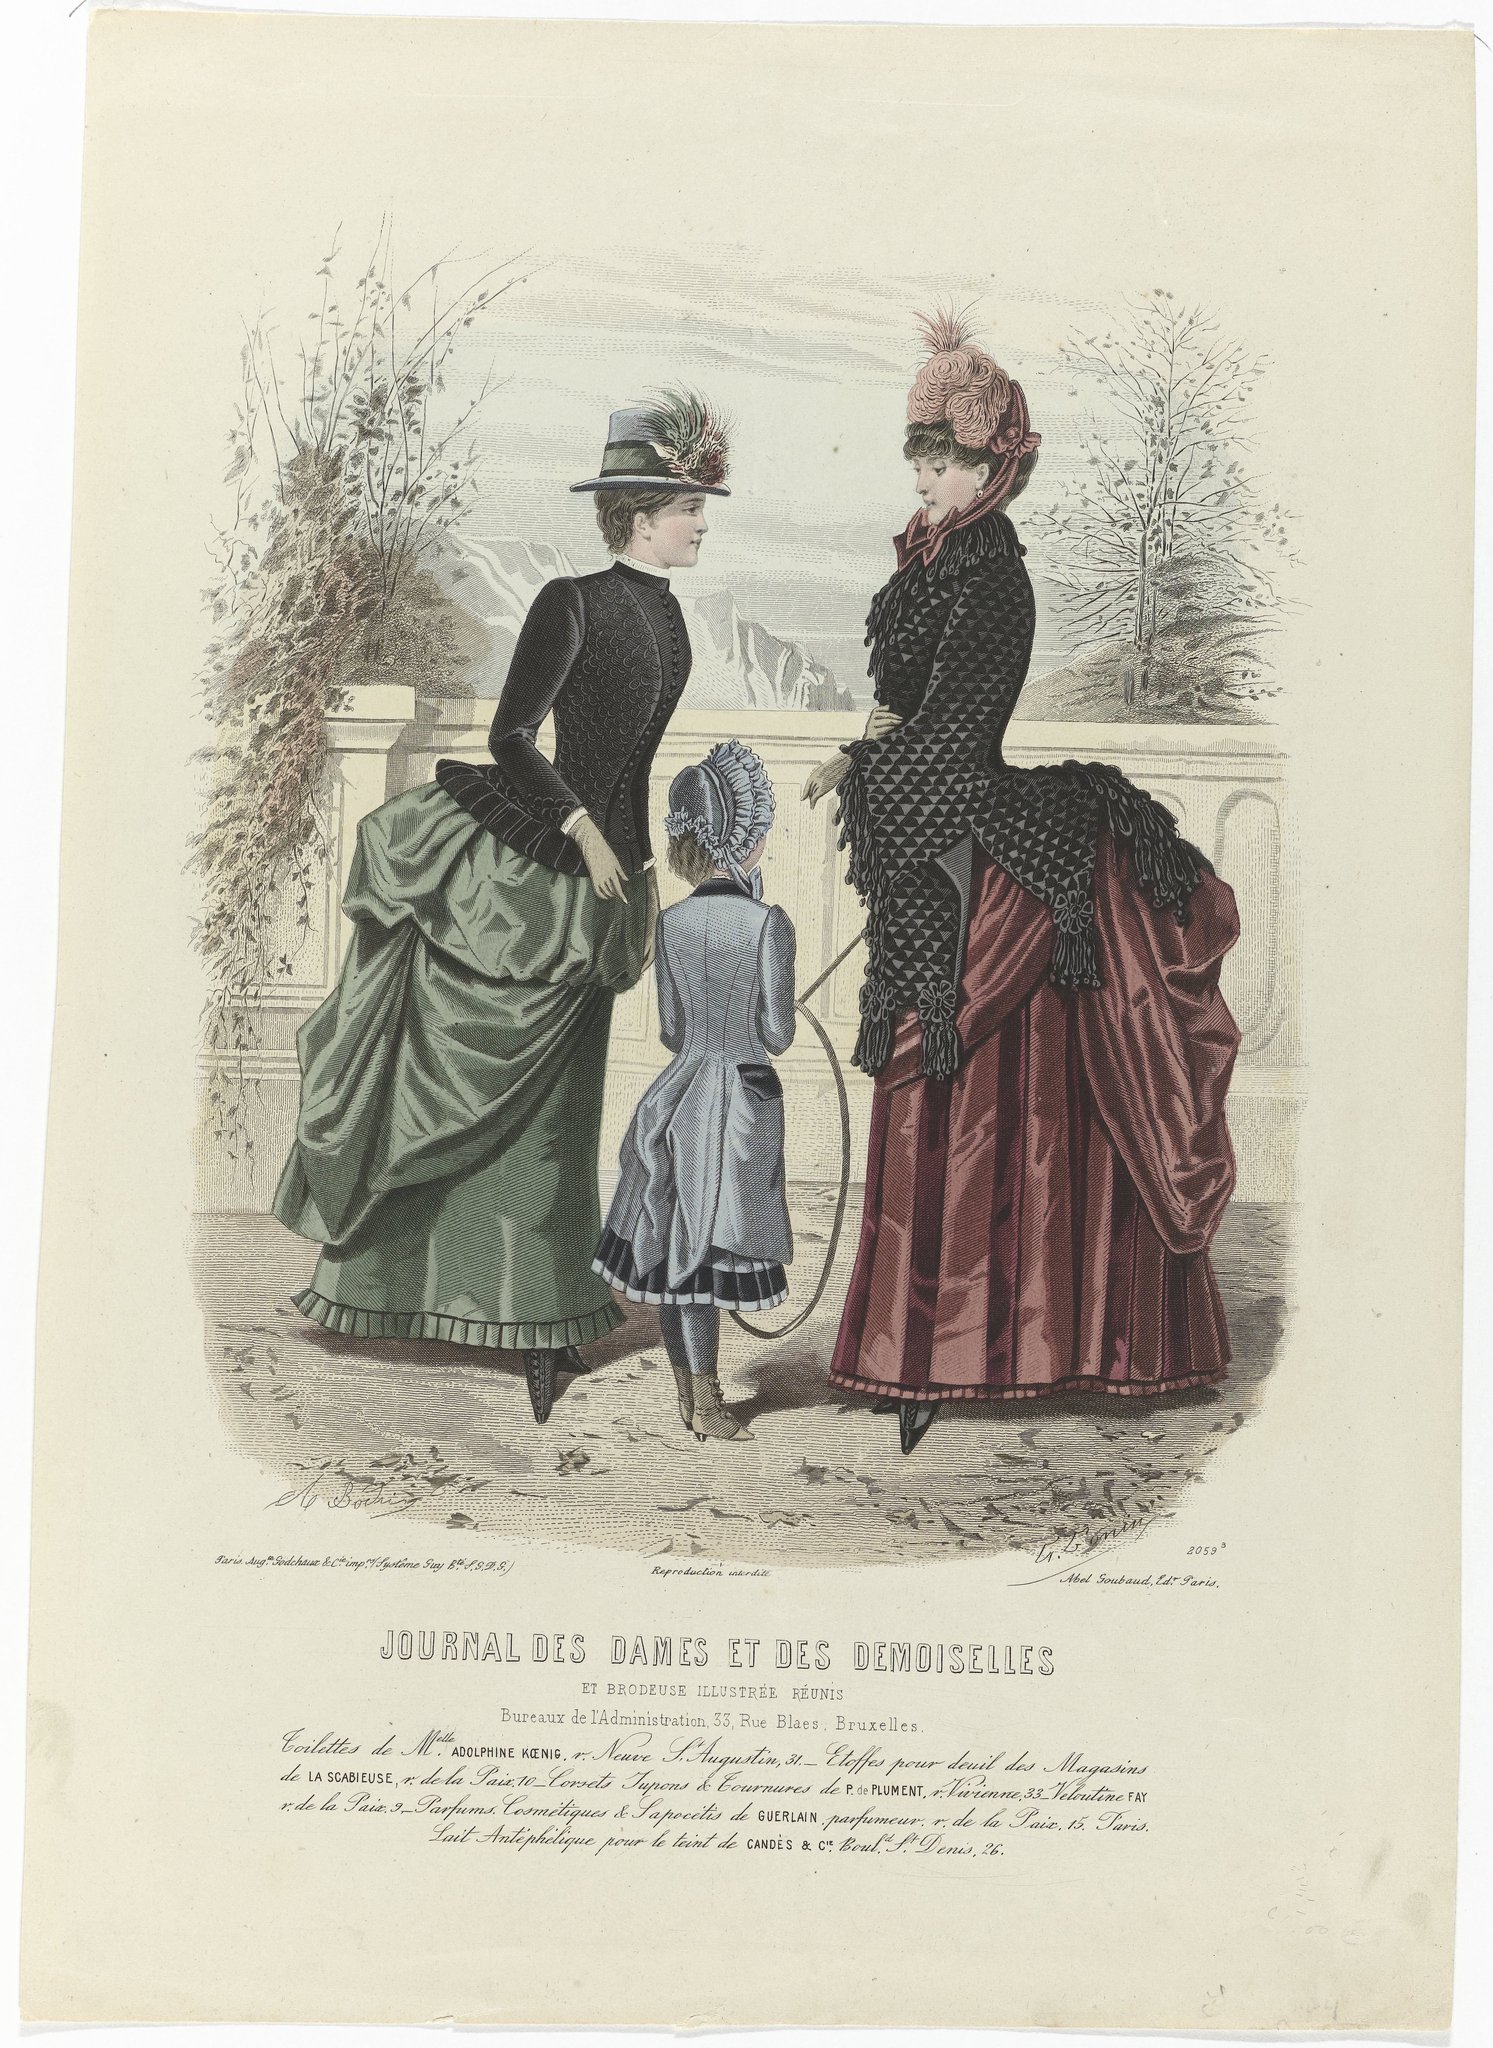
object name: fashion print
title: Le Journal des Dames et des Demoiselles, janvier 1884, No 2059b : Toilettes de Melle Adolphine Koenig (...)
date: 1884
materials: paper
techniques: engraving, hand coloring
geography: paris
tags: skirt (+ girls' clothes), head-gear (+ girls' clothes), boots (+ girls' clothes), coat (+ women's clothes), coat (+ girls' clothes), fashion plates, head-gear: hat (+ women's clothes), shoes, sandals (+ women's clothes), skirt (+ women's clothes), gloves, mittens, etc. (+ women's clothes), (bowling a) hoop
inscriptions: address: ‘Bureaux de l'Administration, 33, Rue Blaes, Bruxelles.’, title: ‘Journal des Dames et des Demoiselles / et brodeuse illustrée réunis’, caption: ‘Toilettes de Melle Adolphine Koenig, r. Neuve S.t Augustin, 31 _ Etoffes pour deuil des Magasins de La Scabieuse, r. de la Paix, 10 _ Corsets Jupons & Tournures de P. de Plument, r. Vivienne, 33 _ Veloutine Fay r. de la Paix. 9 _ Parfums, Cosmetiques & Sapocétis de Guerlain, Parfumeur. r. de la Paix, 15, Paris. Lait Antéphélique pour le teint de Candés & Cie, Boul.d S.t Denis, 26.’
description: Twee vrouwen en een meisje met hoepel en stokje, staande bij een balustrade. Volgens het onderschrift: 'toilettes' van Adolphine Koenig. Hieronder enkele regels reclametekst voor verschillende producten. Prent uit het modetijdschrift Journal des Dames et des Demoiselles (1841-1902).